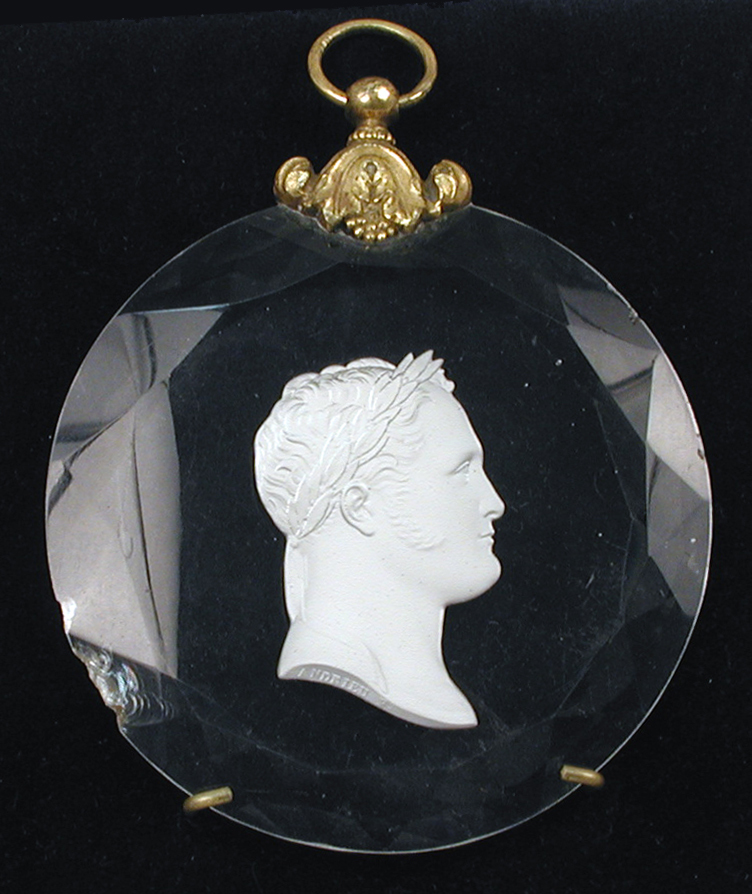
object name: medallion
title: Alexander I of Russia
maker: désprez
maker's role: maker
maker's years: 1773-1815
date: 1801-1900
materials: gilt bronze, glass, porcelain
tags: men,profiles